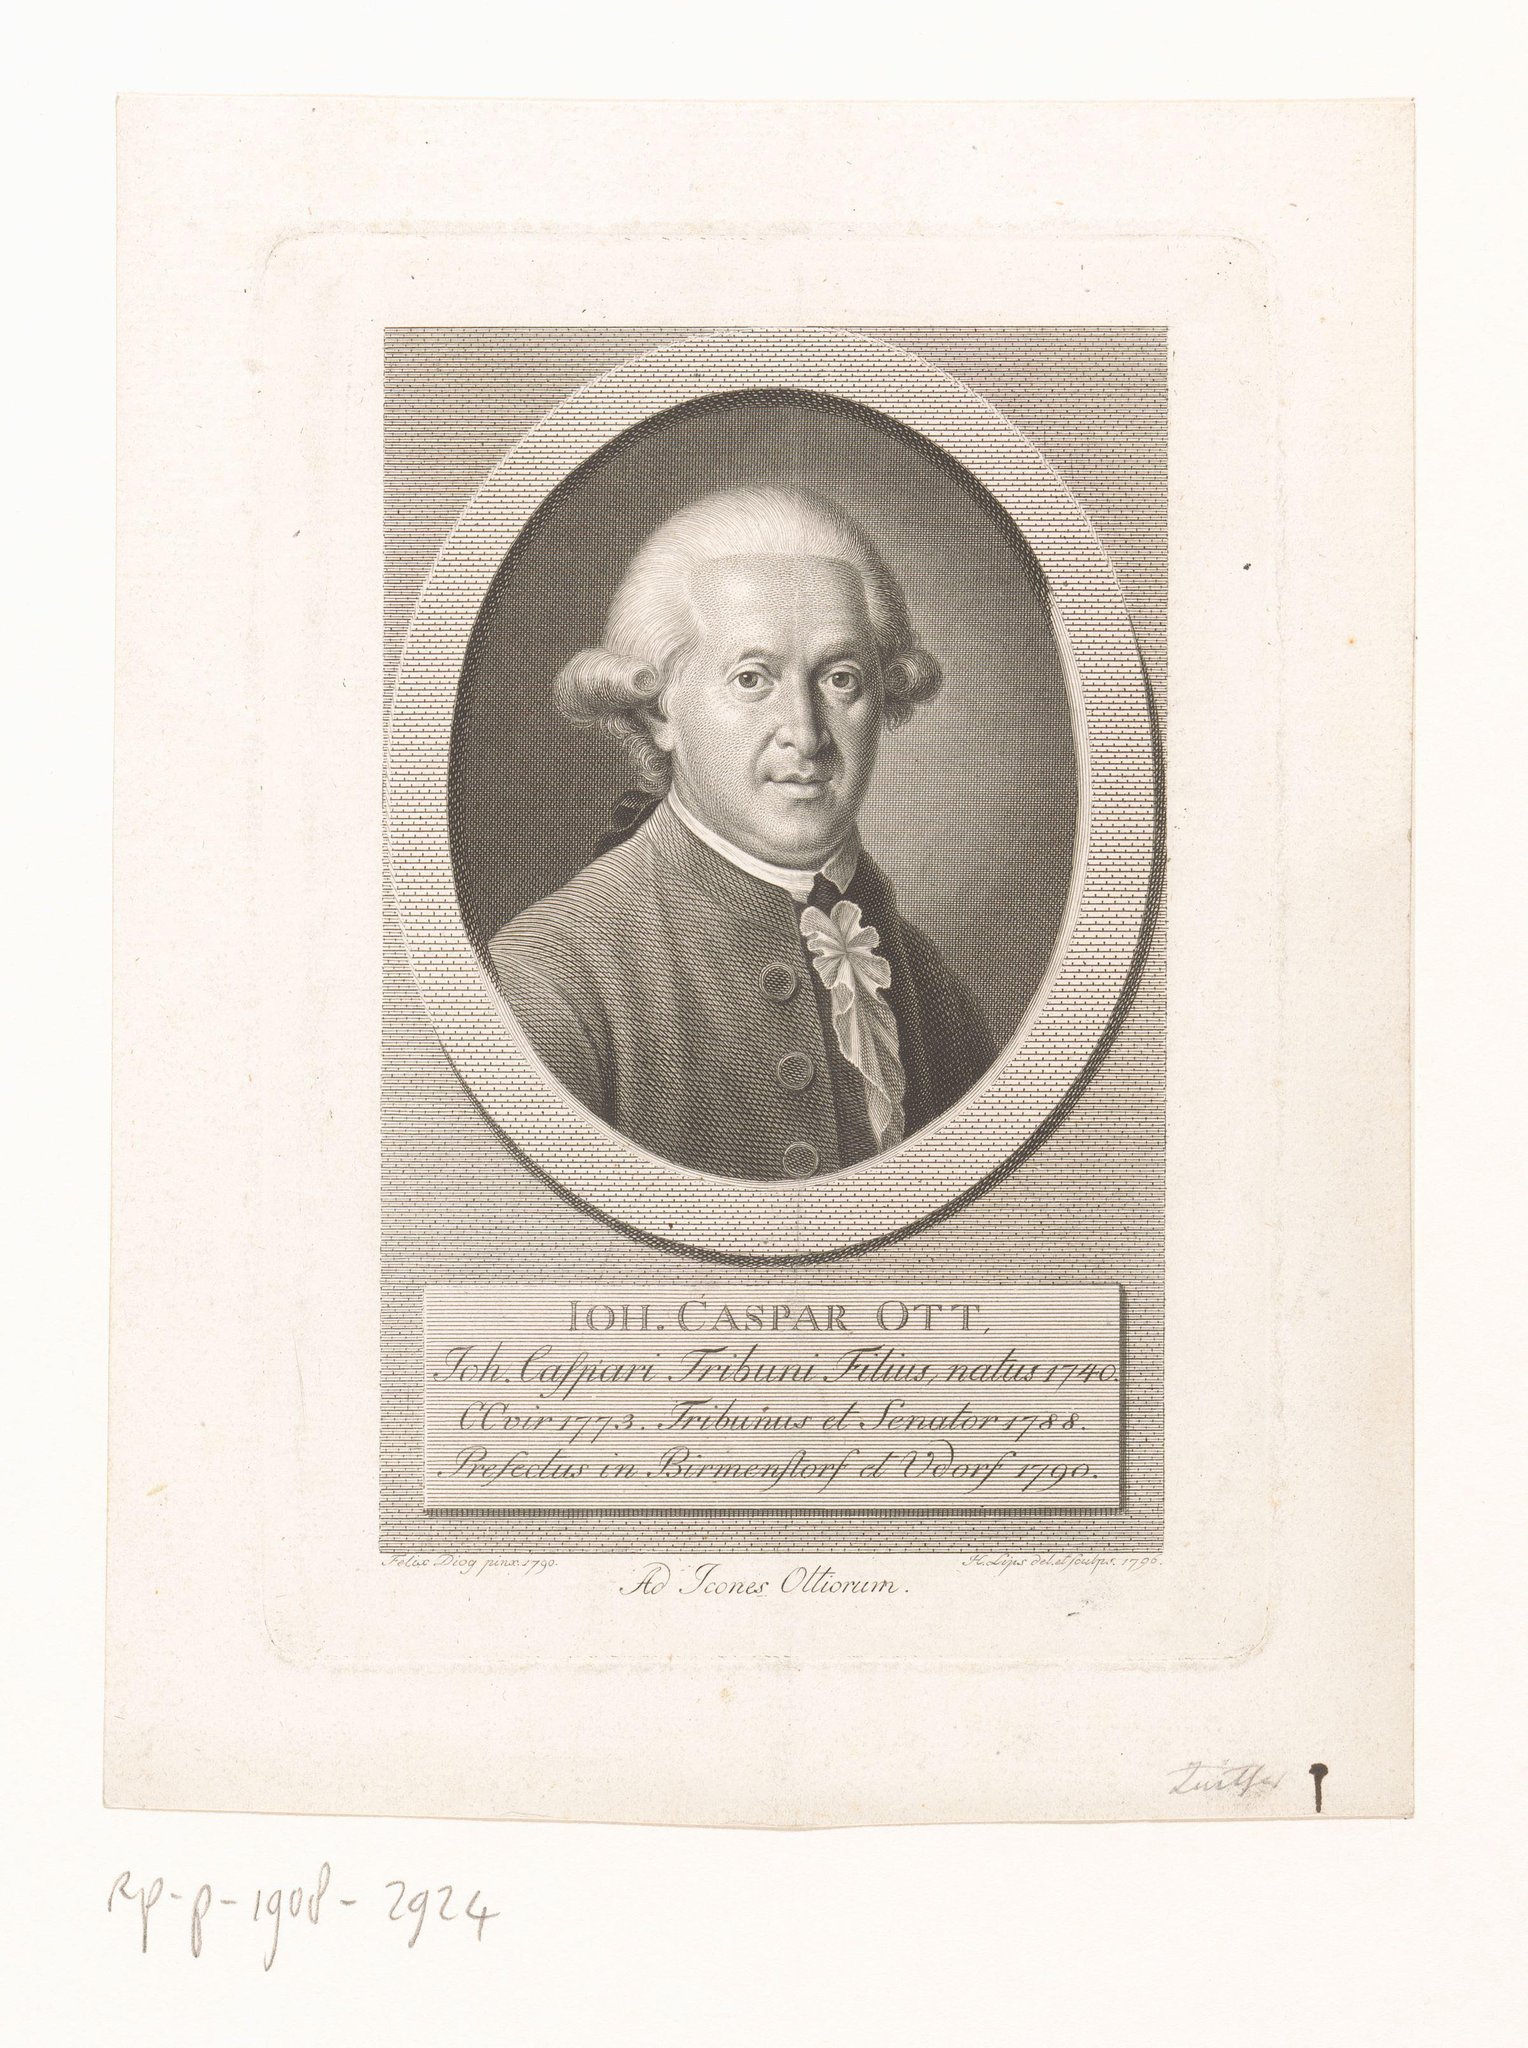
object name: print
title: Portret van Hans Kaspar Ott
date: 1796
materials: paper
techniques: engraving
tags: historical persons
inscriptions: collector's mark: Lugt 2228